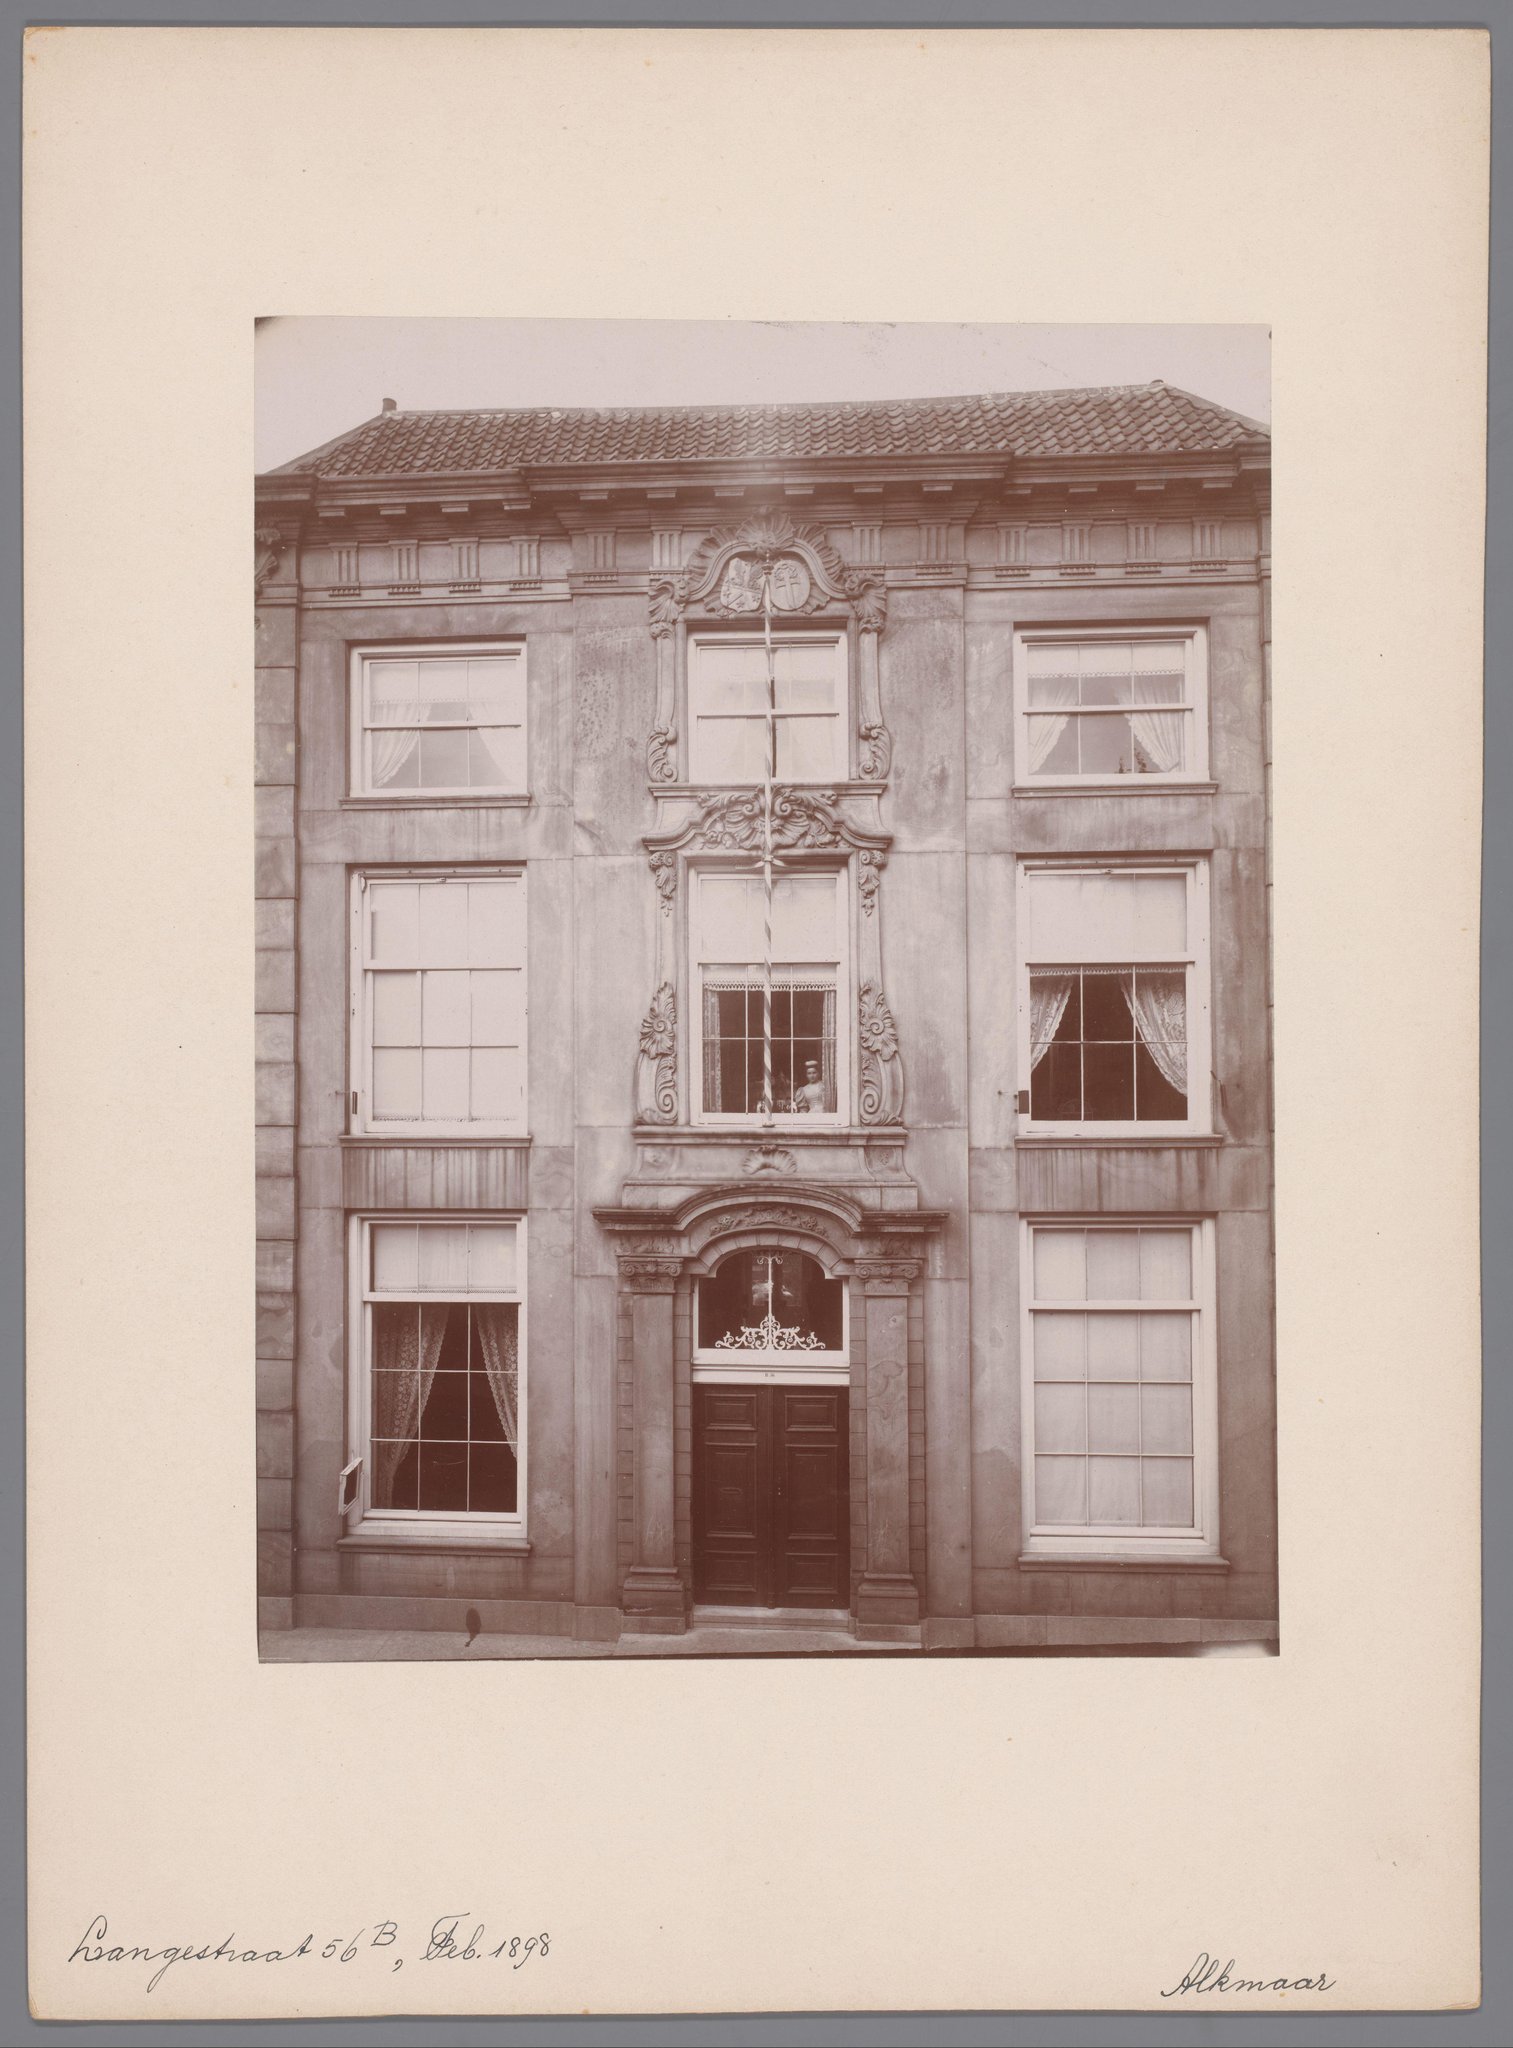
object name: photograph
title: Façade van Langestraat 56B te Alkmaar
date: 1898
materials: cardboard, photographic support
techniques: gelatin silver print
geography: langestraat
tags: urban housing, façade (of house or building)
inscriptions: annotation: ‘Langestraat 56B, Feb. 1898/ Alkmaar’, annotation: ‘Alkmaar/ Huis No. 56B Langestraat/ feb 1898’